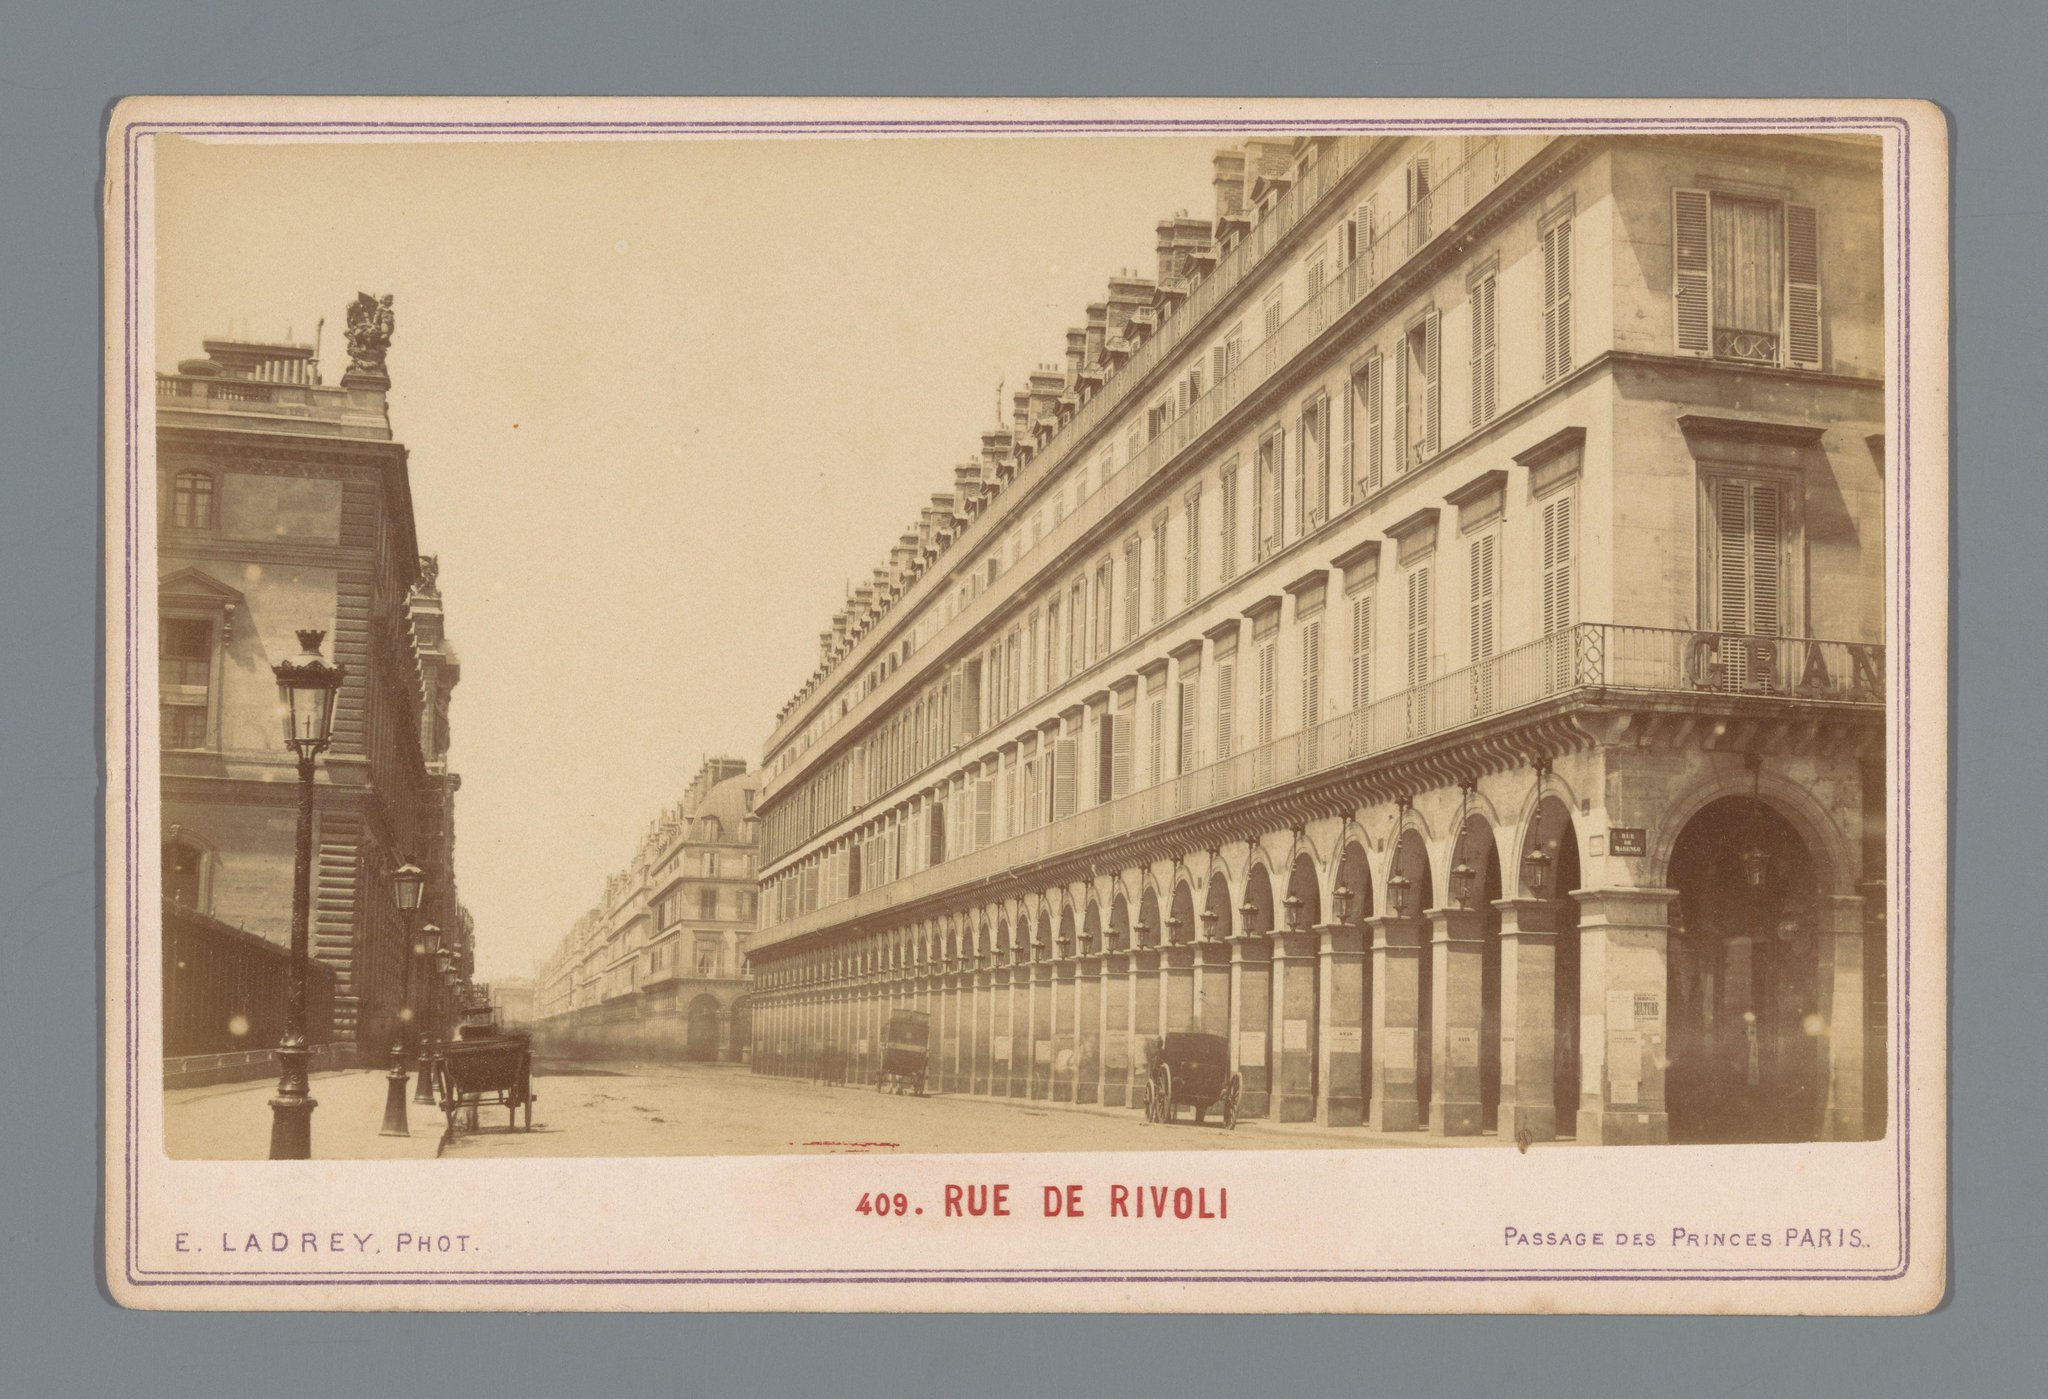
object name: cabinet photograph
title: Rue de Rivoli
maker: ernest ladrey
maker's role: fotograaf, illustrator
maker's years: 1830-1889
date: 1860-1890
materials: cardboard, photographic support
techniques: albumen print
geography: paris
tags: city-view in general; 'veduta', street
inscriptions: number: ‘409.’, retailer's mark: ‘Maison Martinet/ 12, boulevard des capucines 12/ Grand-Hotel, Paris.’, address: ‘Passage des Princes PARIS.’